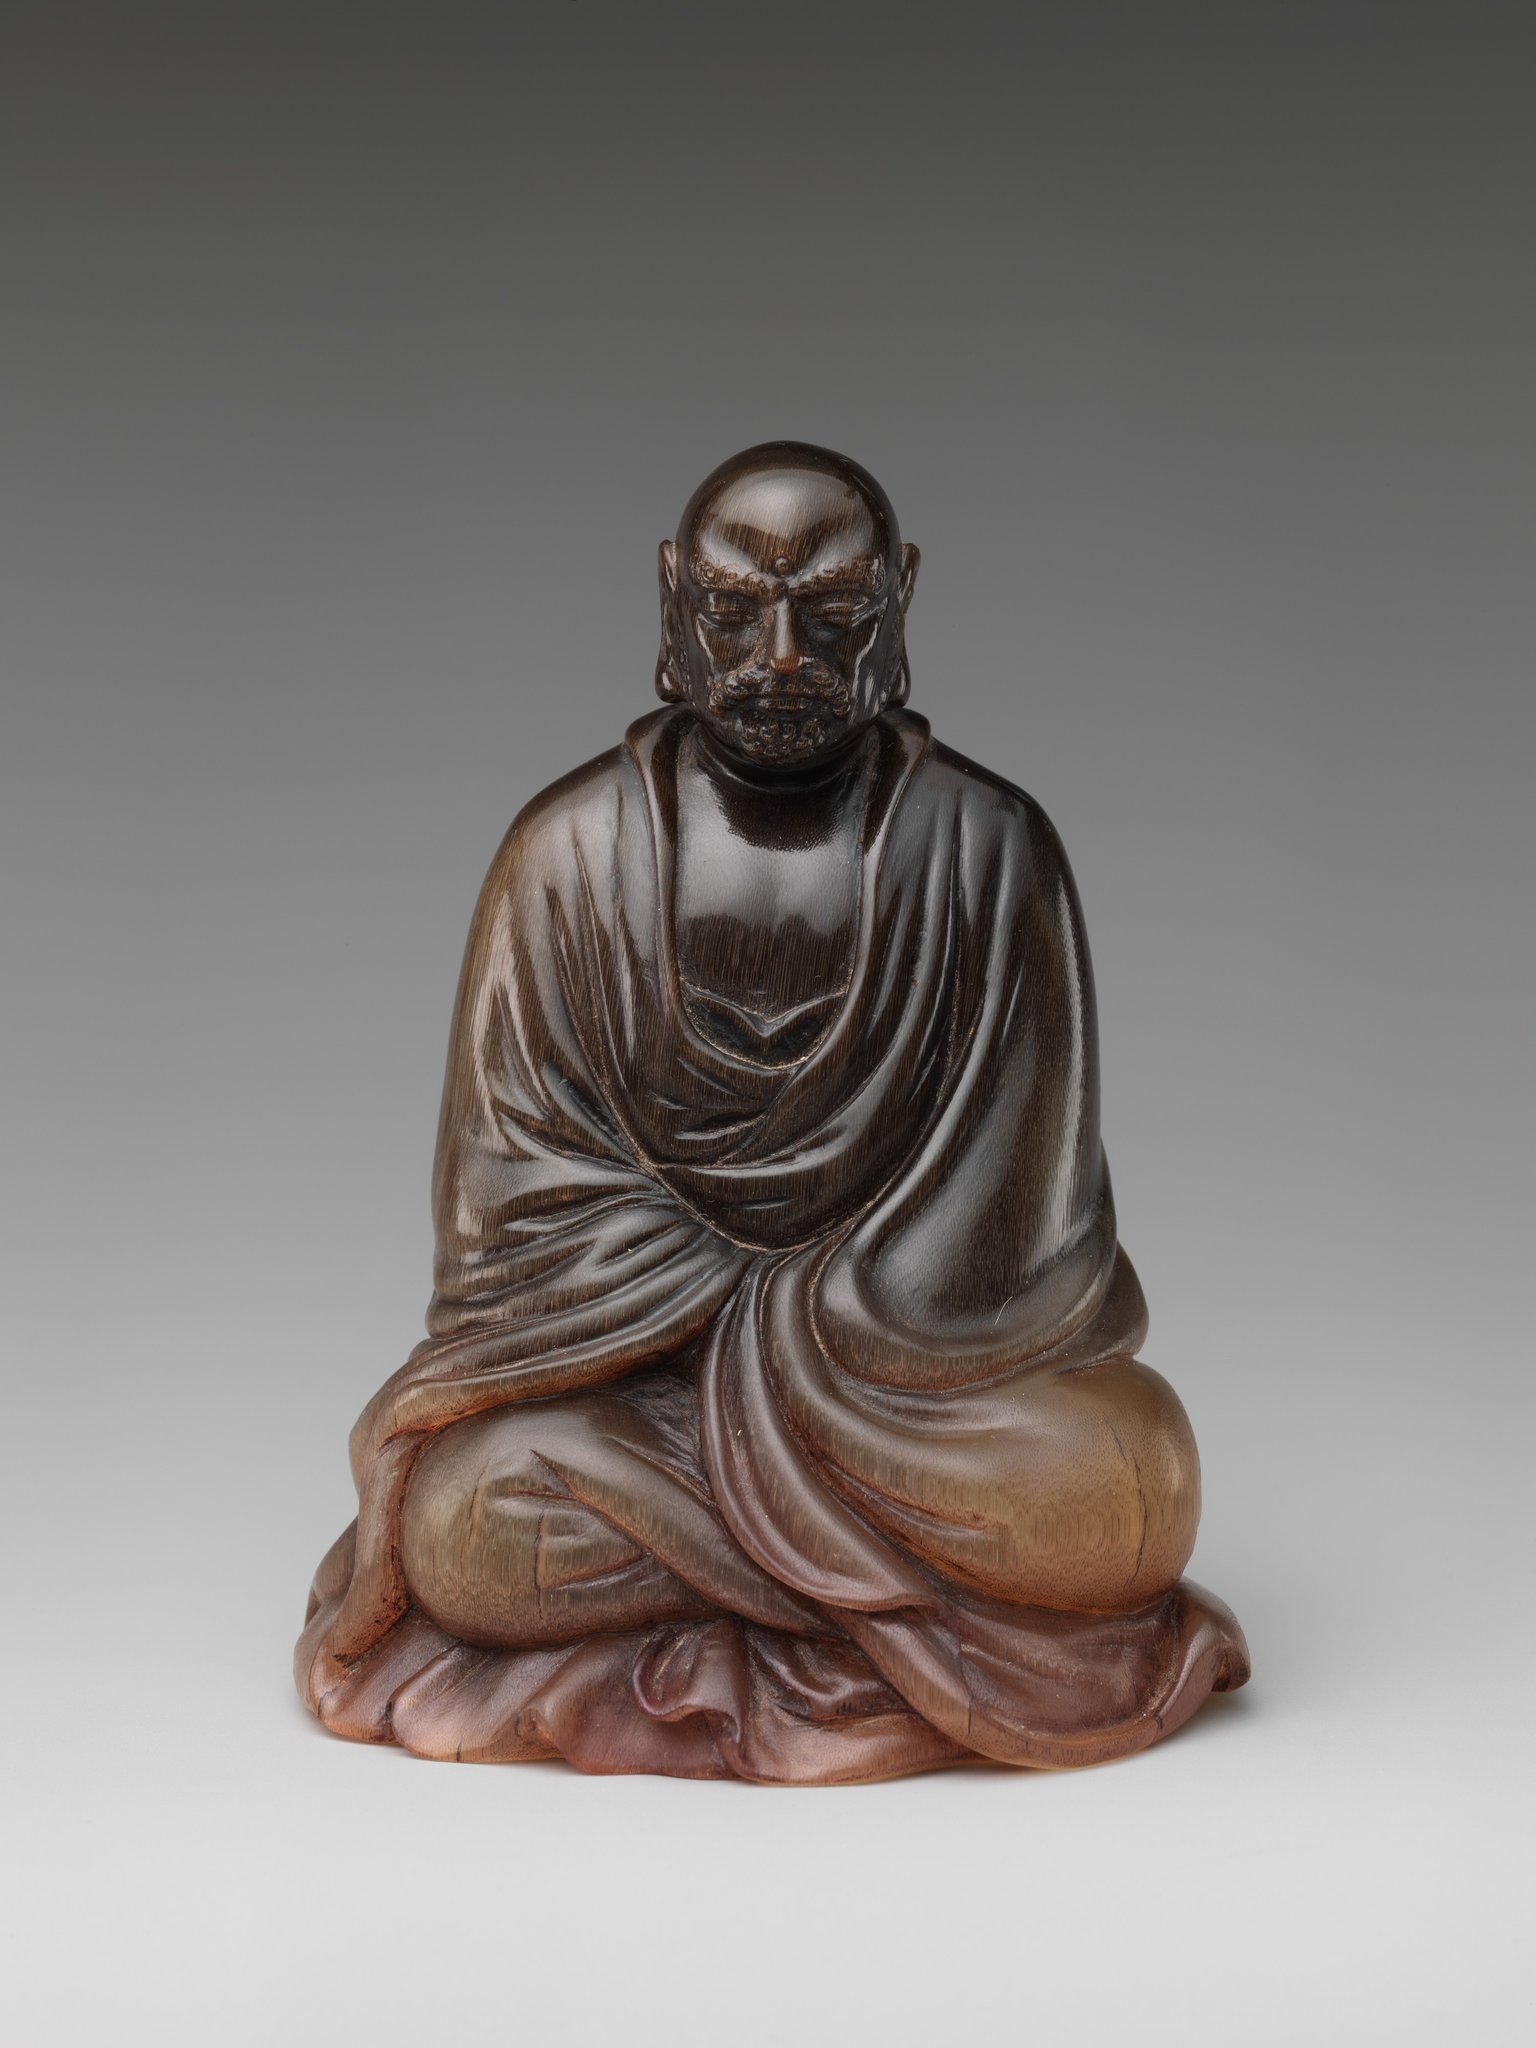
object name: figurine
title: Buddhist monk Bodhidharma (Chinese: Damo)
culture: chinese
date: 1601-1700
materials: horn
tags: men,buddhism,monks